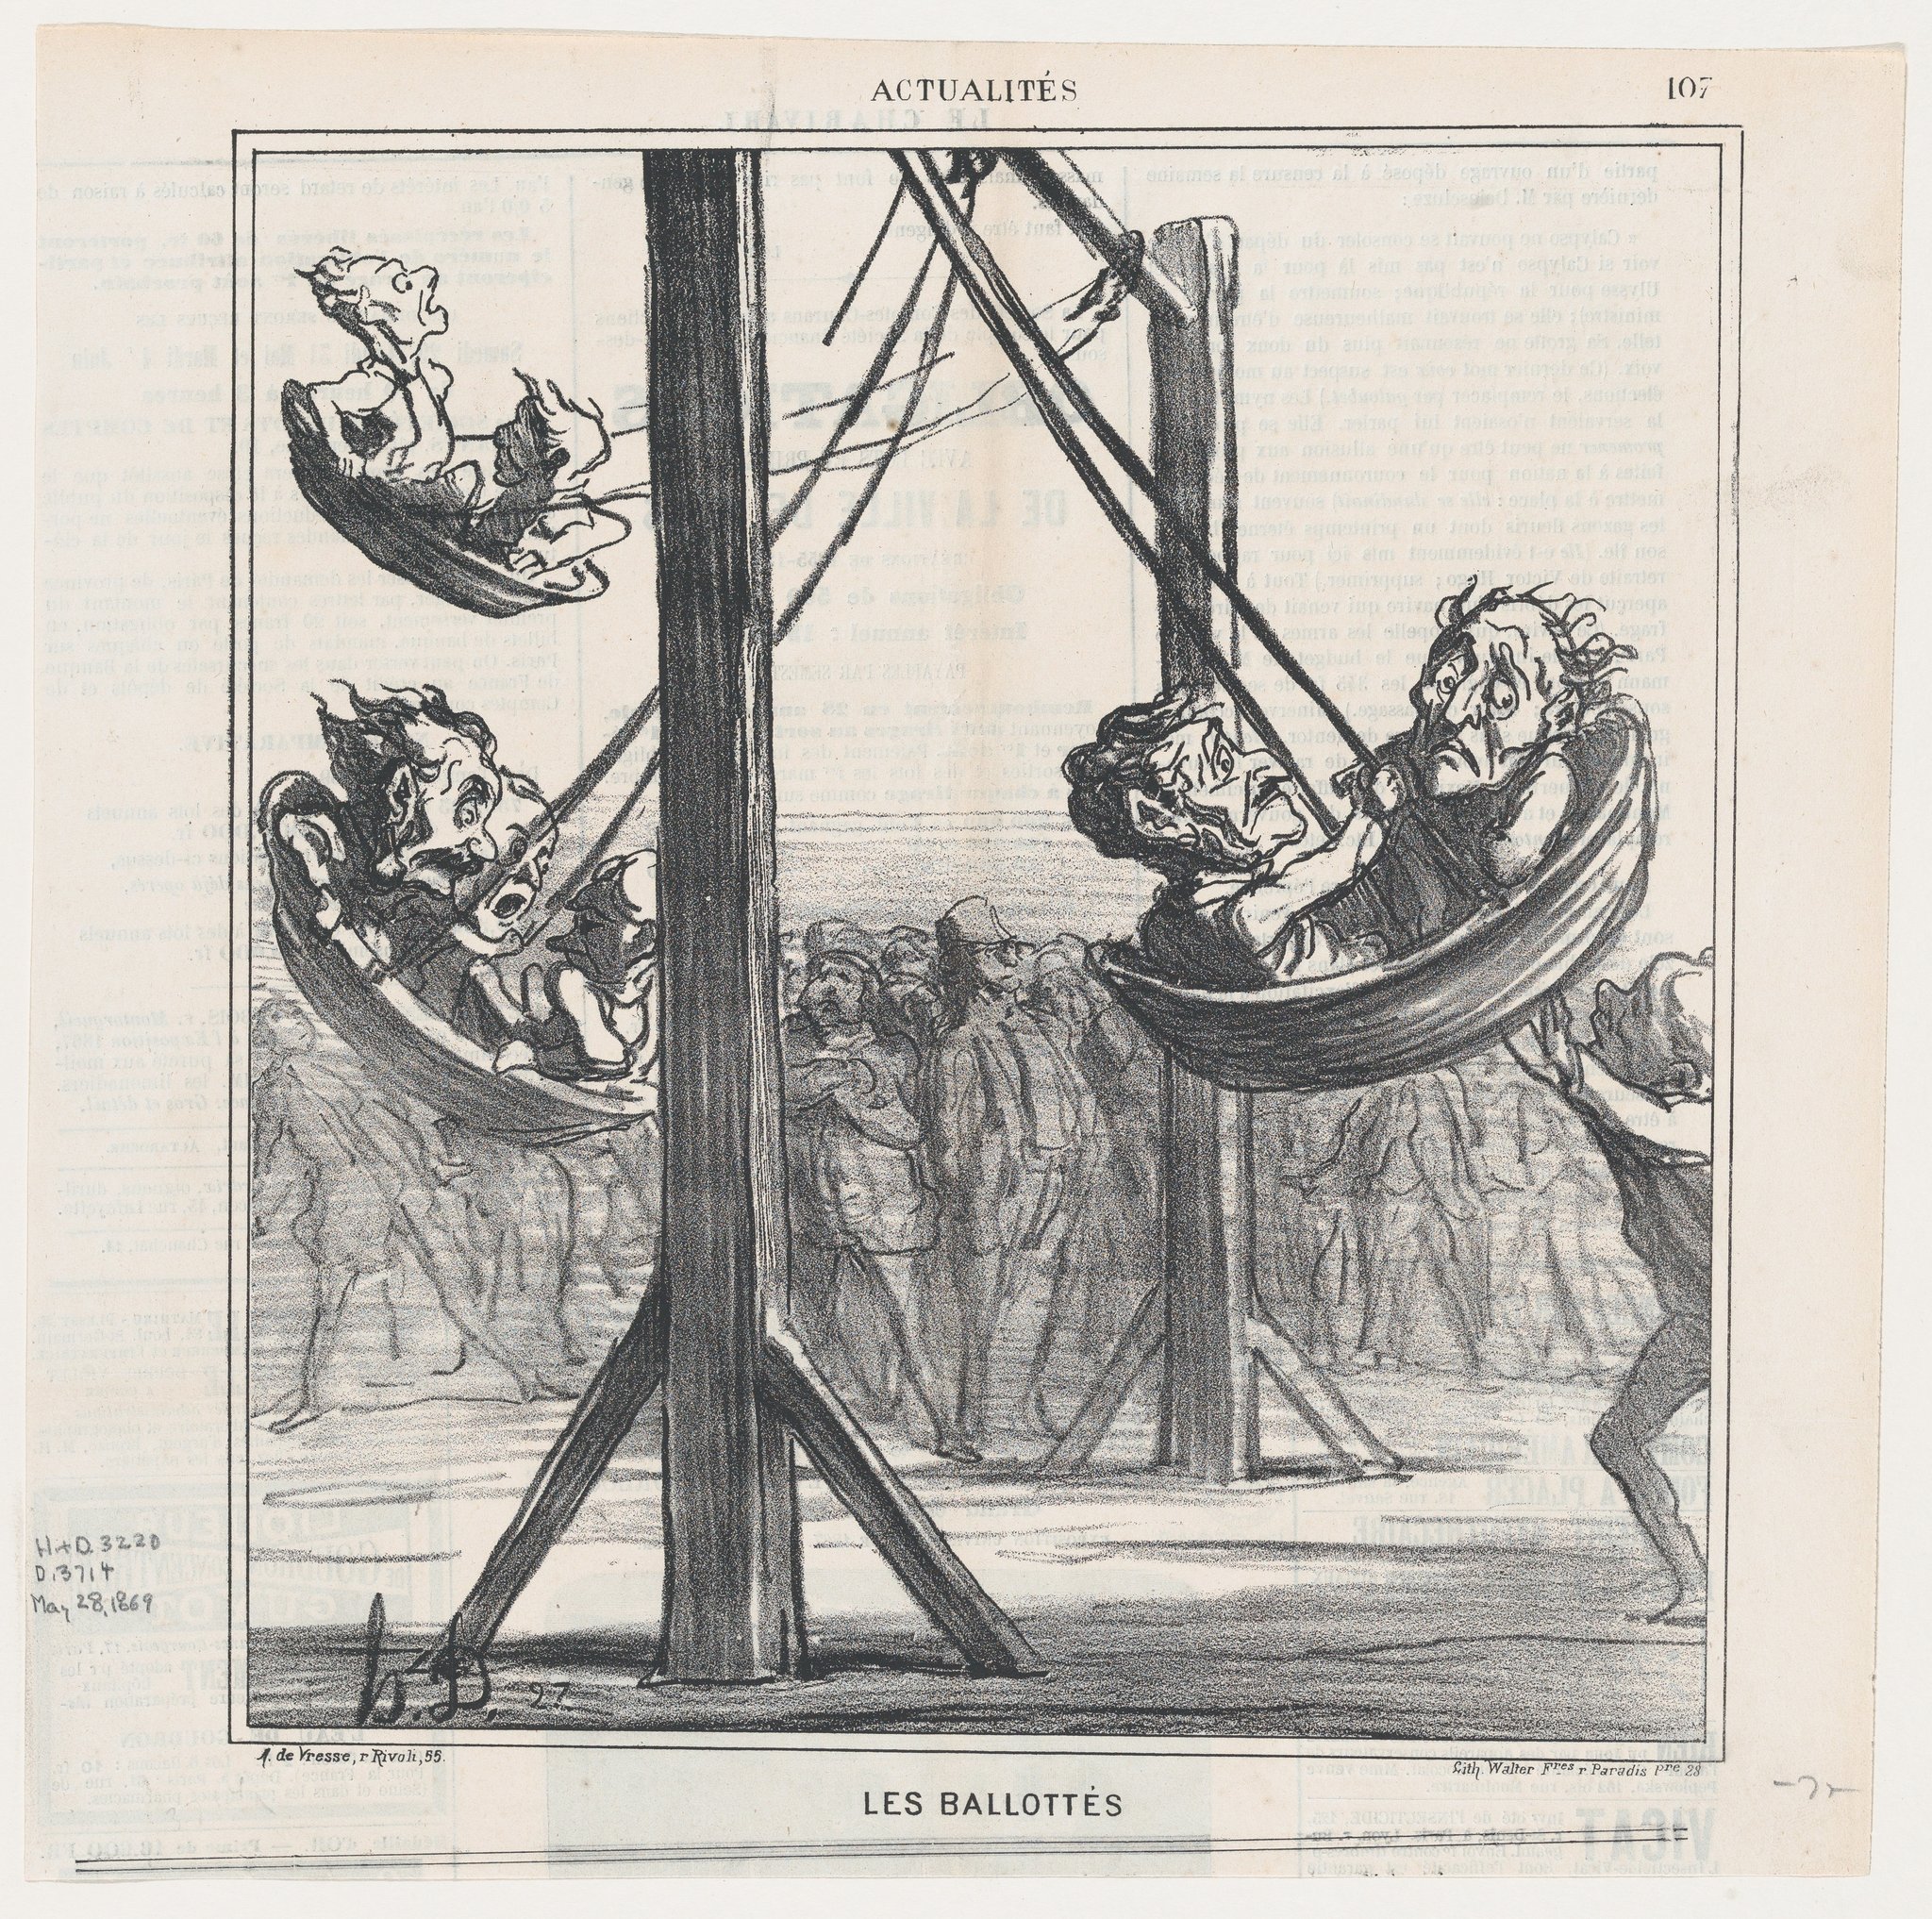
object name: print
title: Run-off elections, from 'News of the day,' published in Le Charivari, May 28, 1869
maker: honoré daumier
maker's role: artist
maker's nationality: french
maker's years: 1808-1879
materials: paper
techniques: lithograph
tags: satire,men